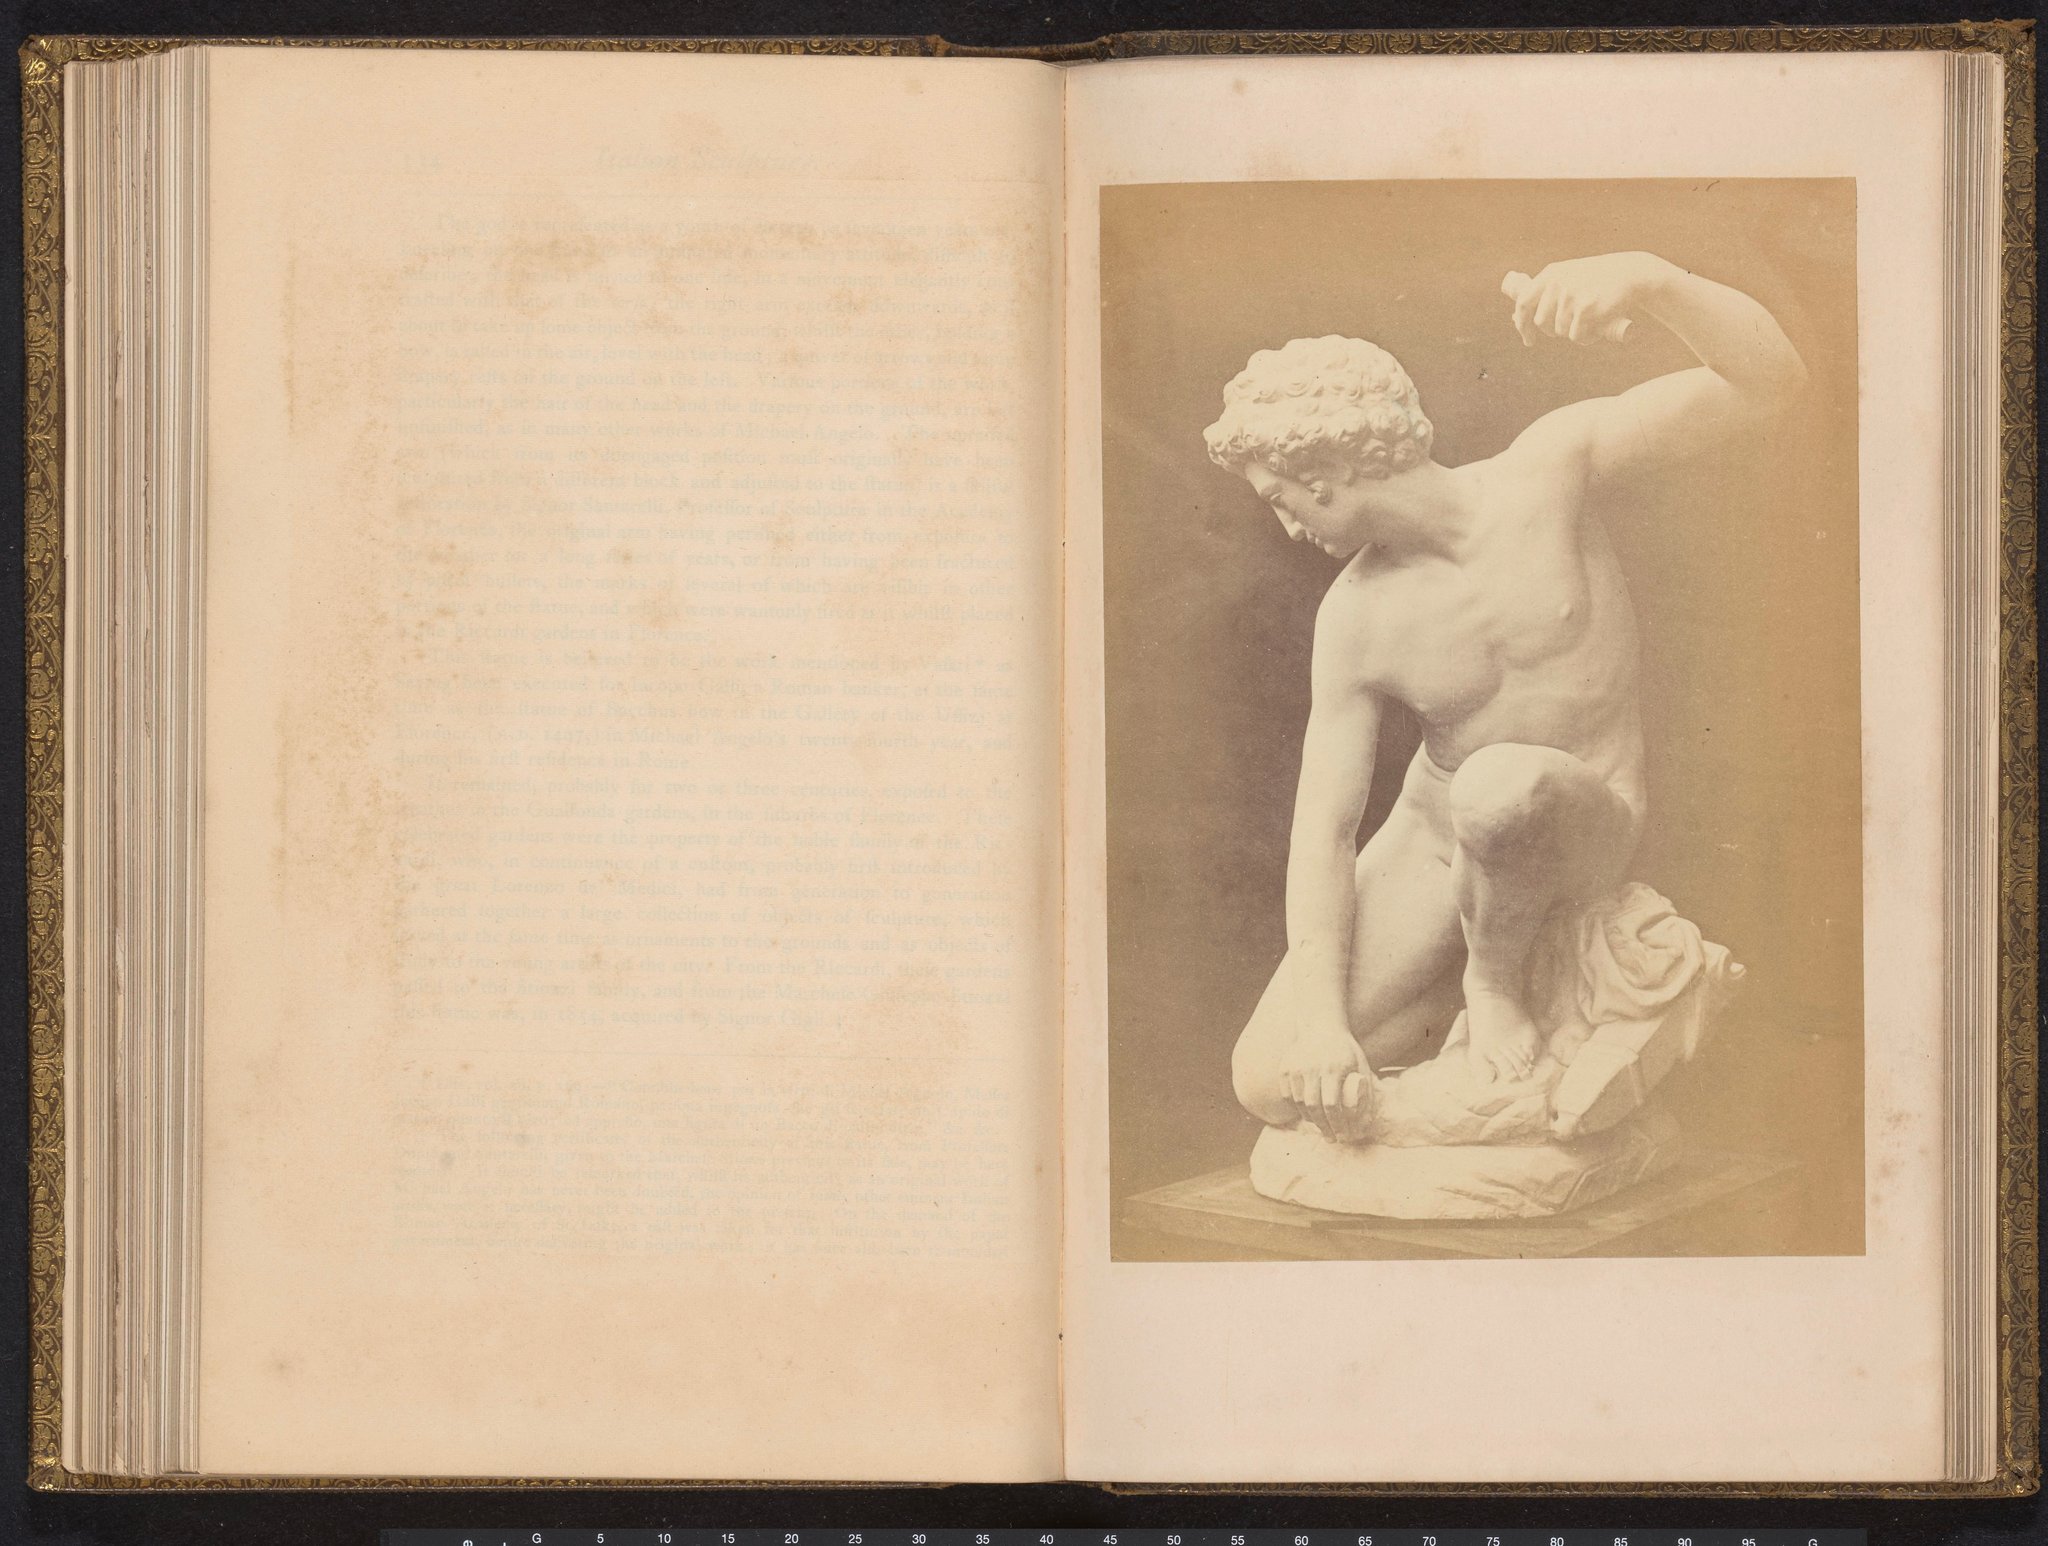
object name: page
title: Romeinse sculptuur van Narcissus, gerestaureerd door Valerio Cioli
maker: Anonymous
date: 1852-1862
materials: photographic support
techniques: albumen print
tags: (story of) narcissus, sculpture (+ relief ~ sculpture)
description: In het boek nog beschreven als een sculptuur van Cupido door Michelangelo.